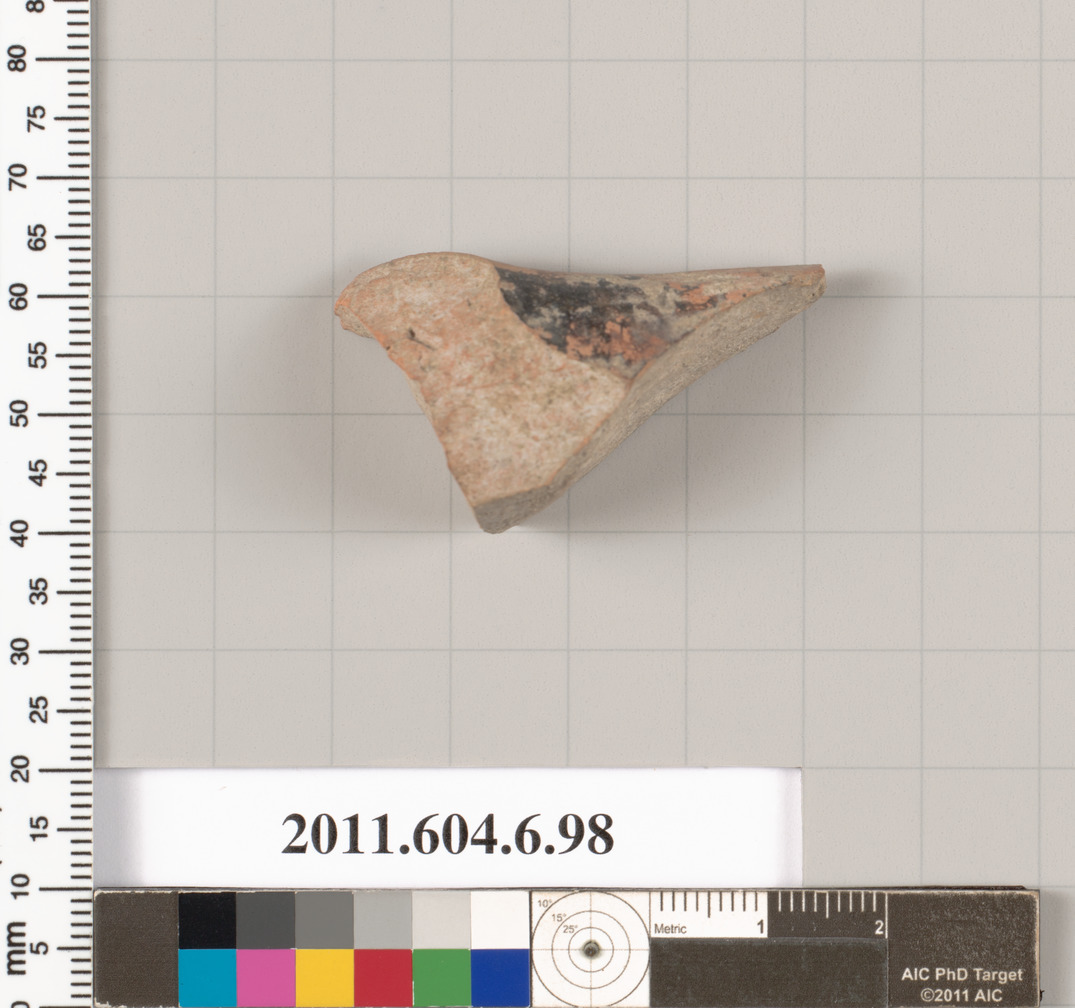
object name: undetermined shape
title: Terracotta rim fragment of an undetermined shape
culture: greek, attic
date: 600-401 BCE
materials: terracotta